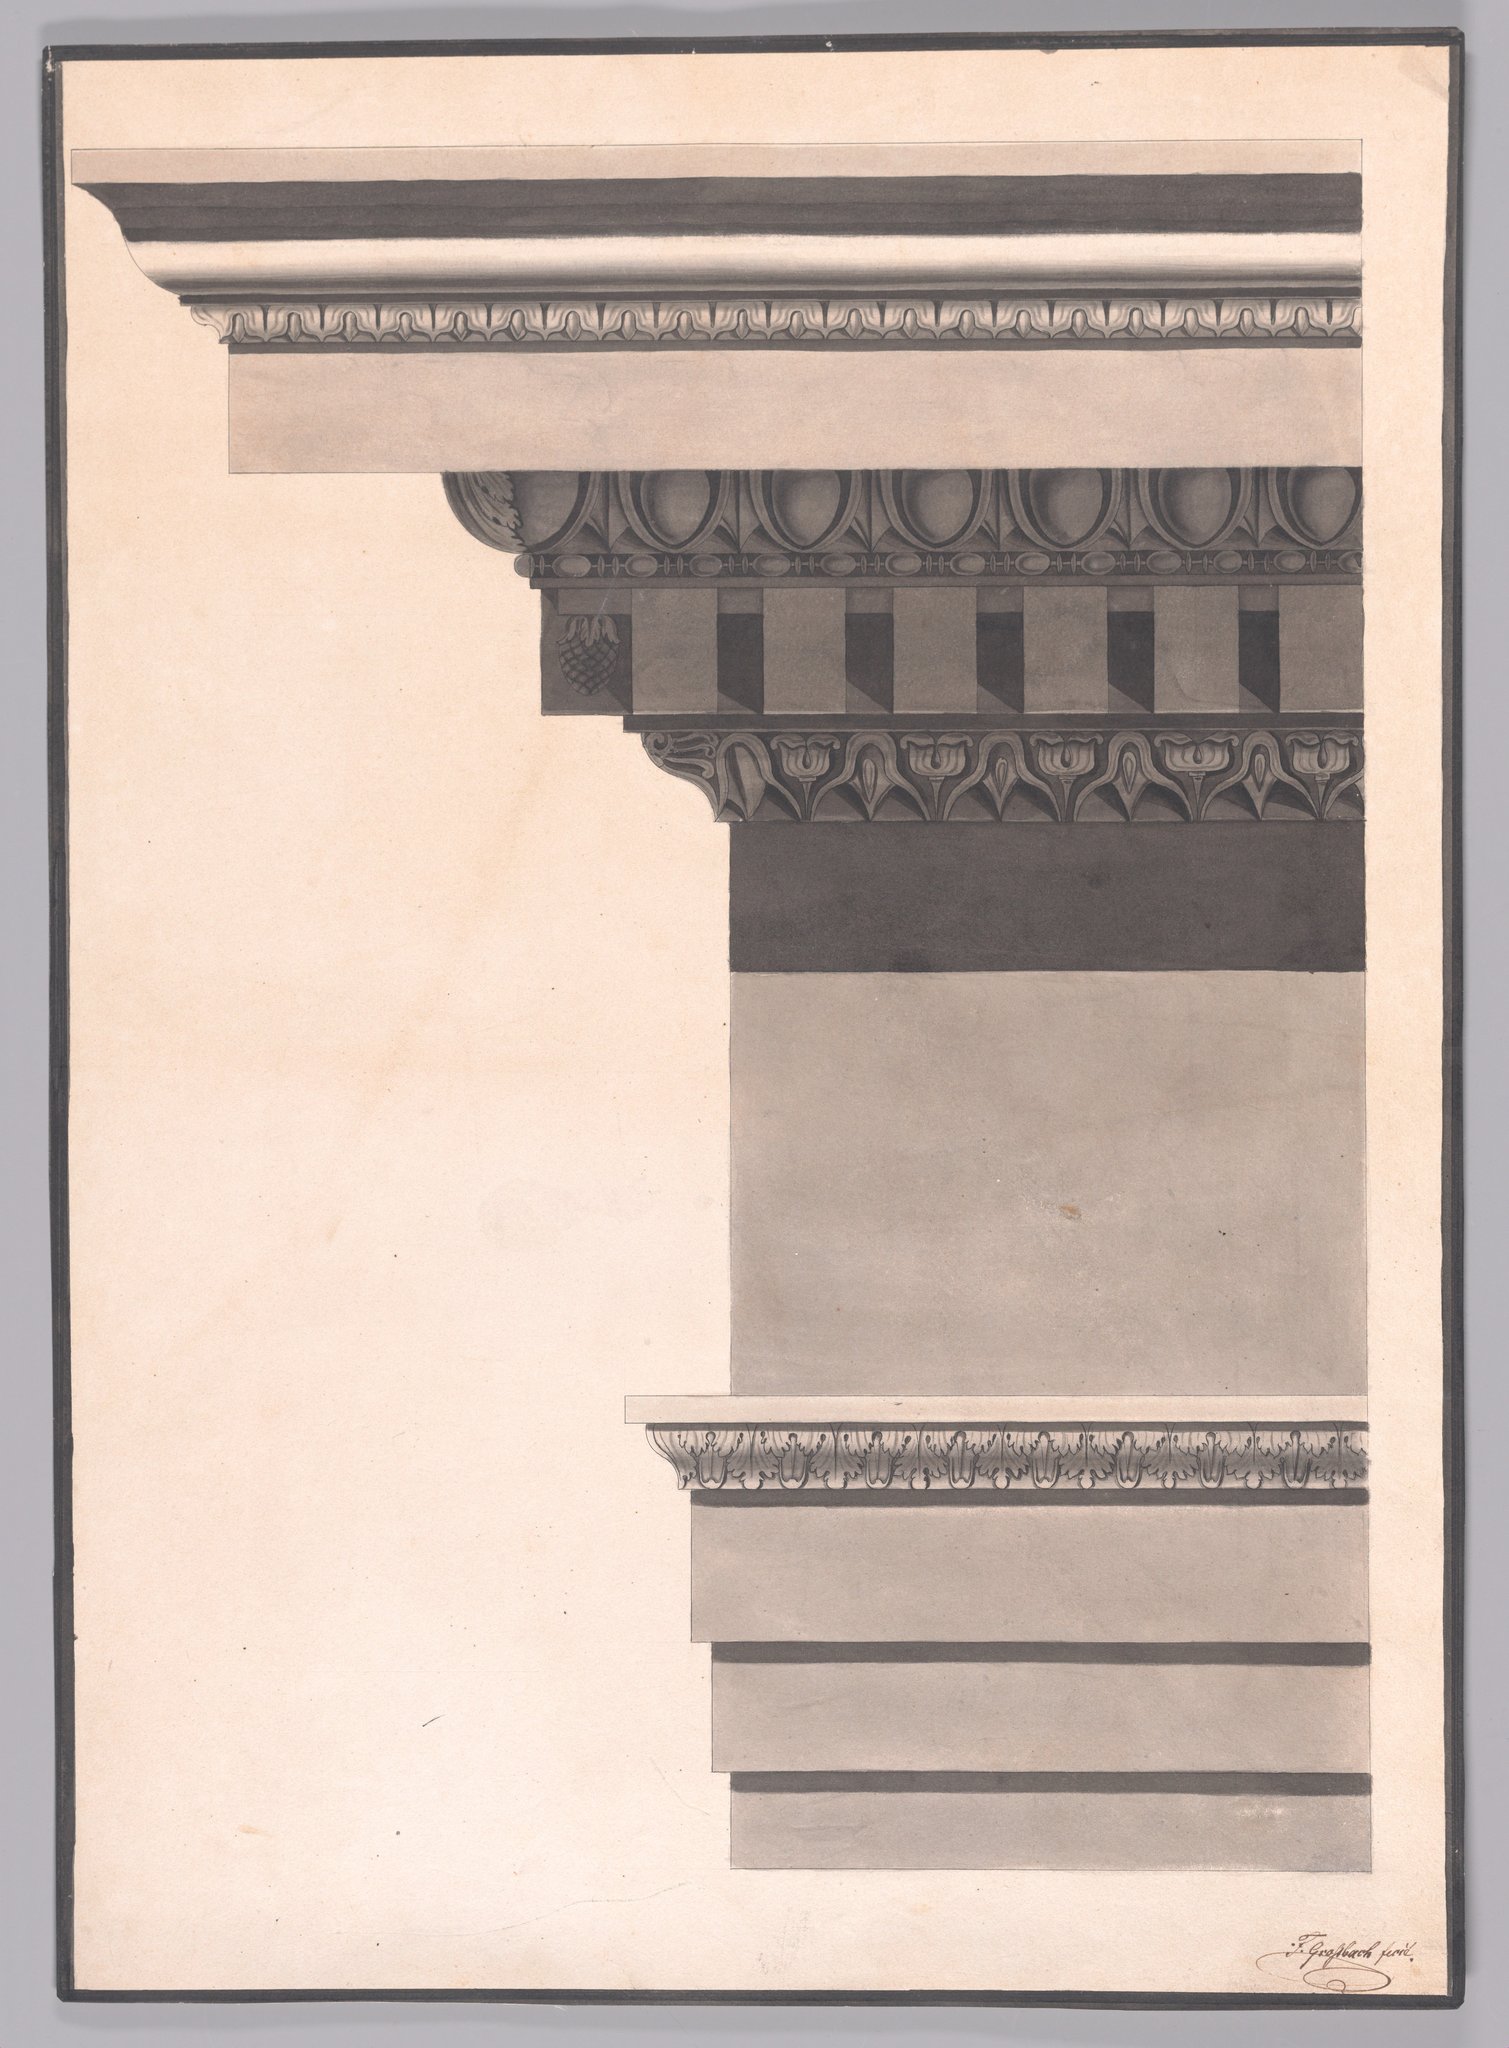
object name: drawing ornament architecture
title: Architectural Study of Classical Entablature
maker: f. or t. grossbach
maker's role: artist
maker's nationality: central european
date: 1801-1900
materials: chalk, ink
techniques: pen, wash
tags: architecture